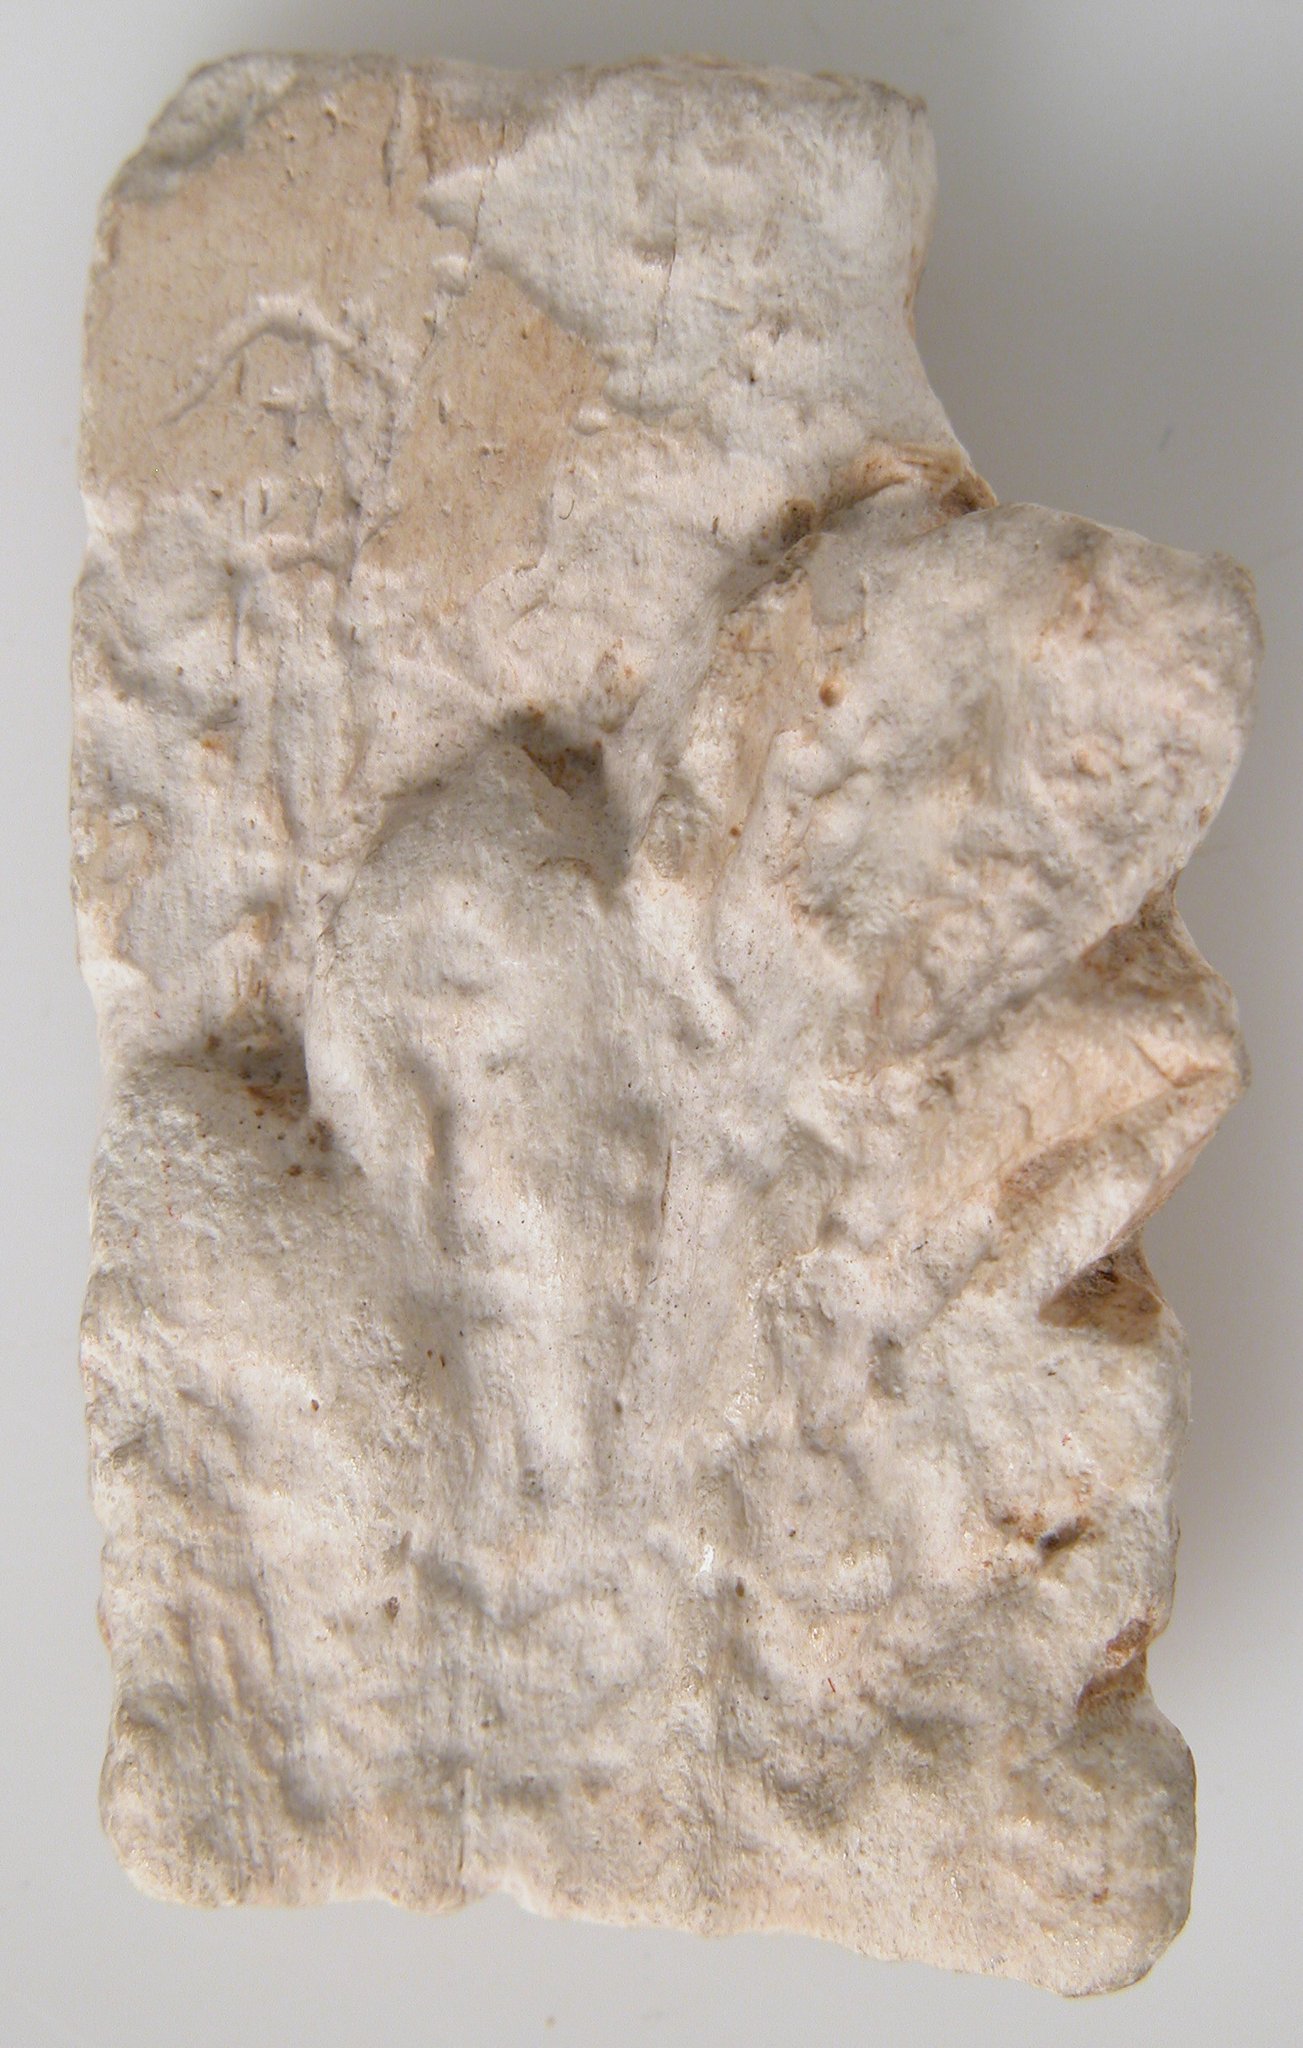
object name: fragment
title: Relief Fragment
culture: coptic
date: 501-700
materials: ivory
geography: egypt